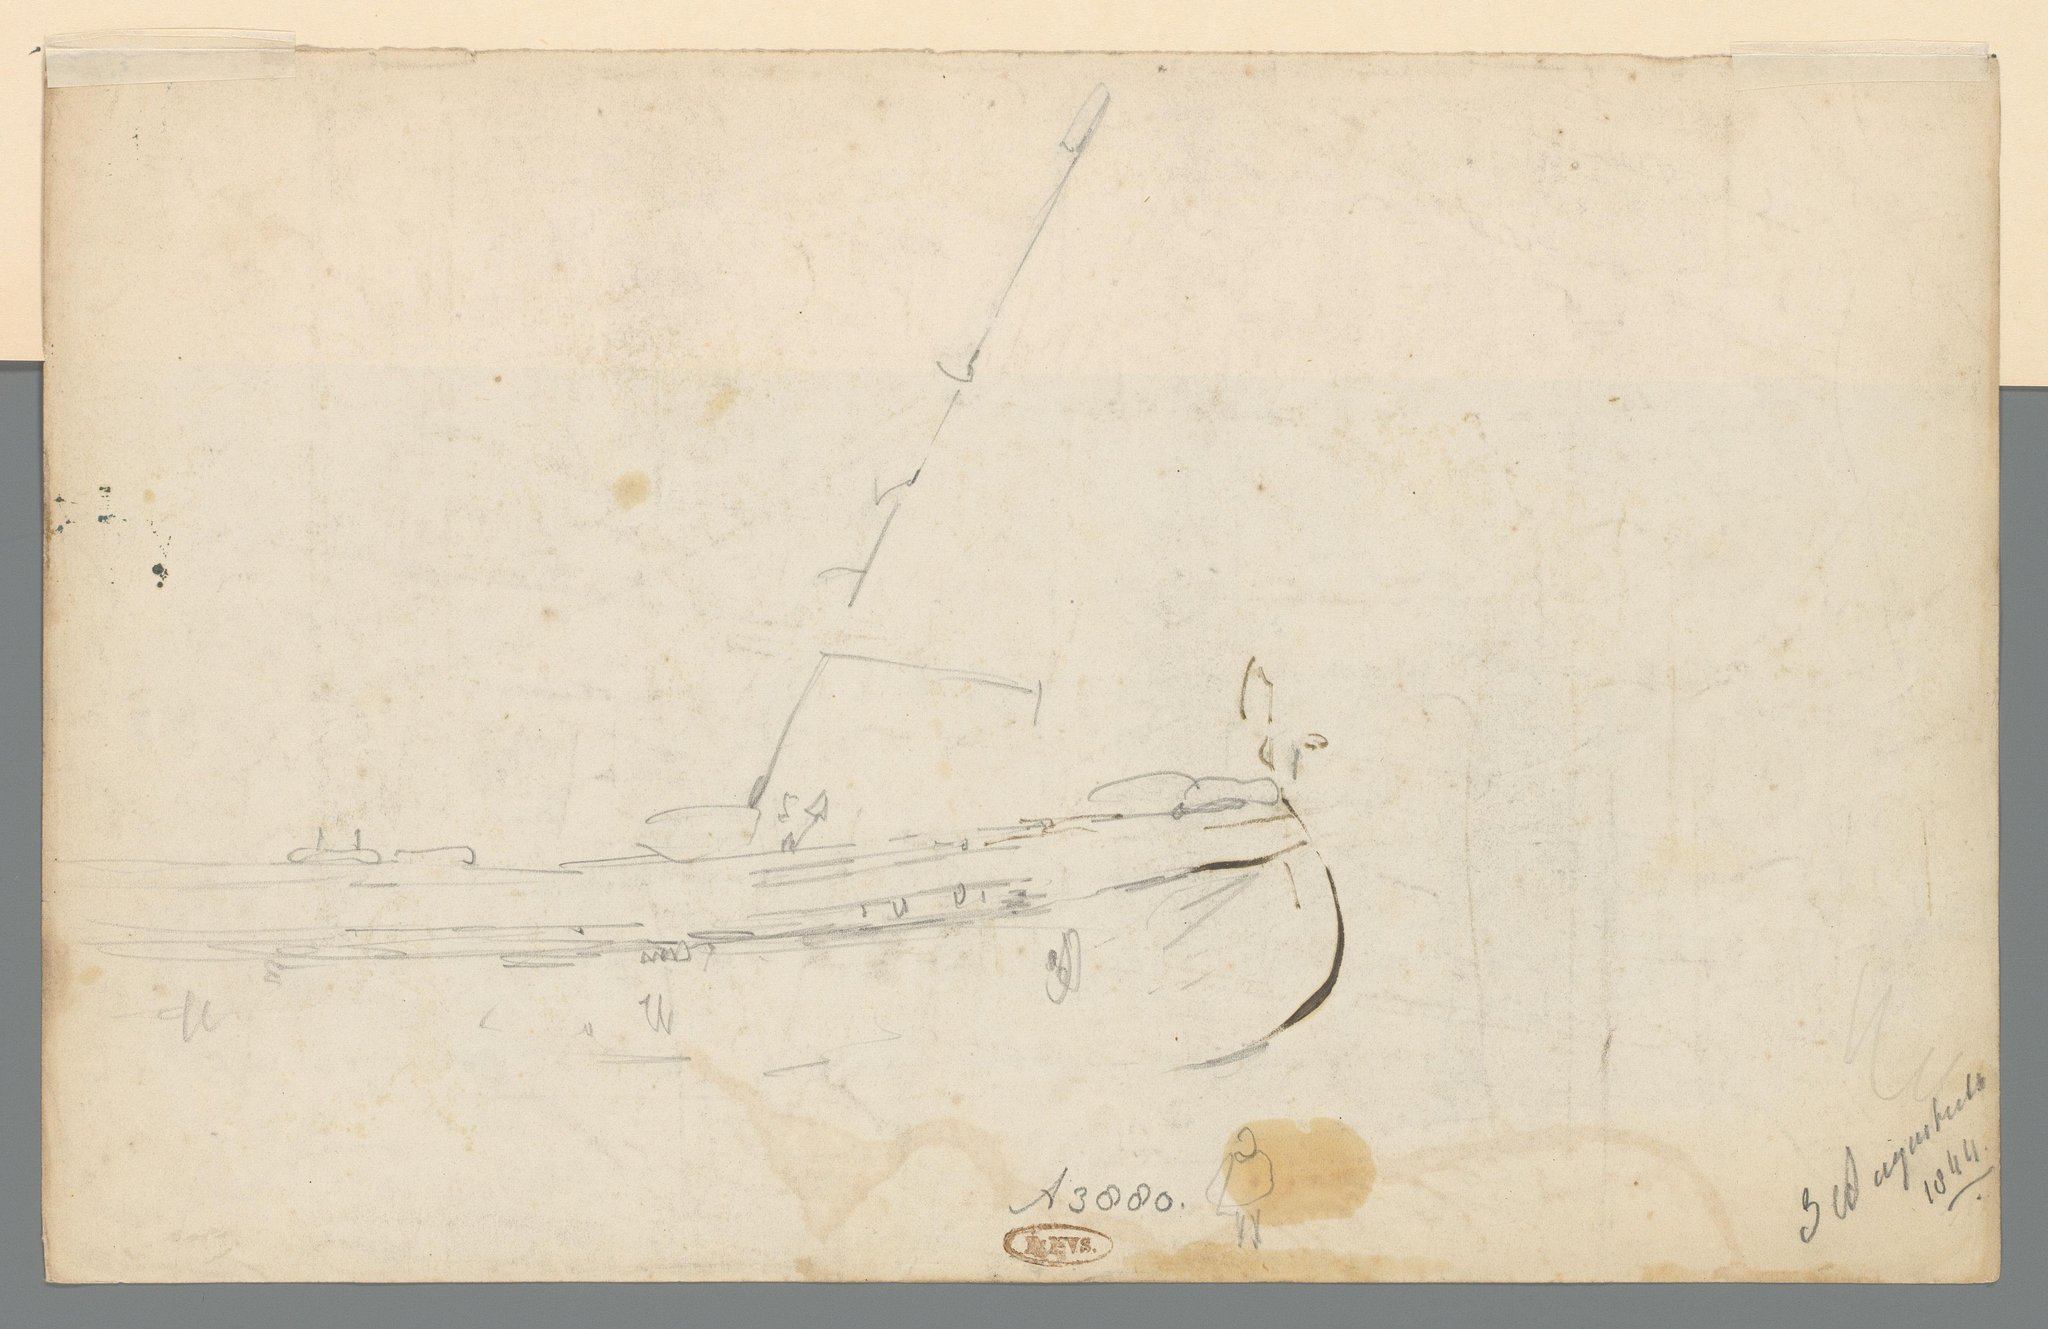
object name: drawing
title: Schets van een schip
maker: willem anthonie van deventer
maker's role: draughtsman, painter, print maker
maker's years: 1824-1893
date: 1844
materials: ink, paper, pencil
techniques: pen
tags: sailing-ship, sailing-boat